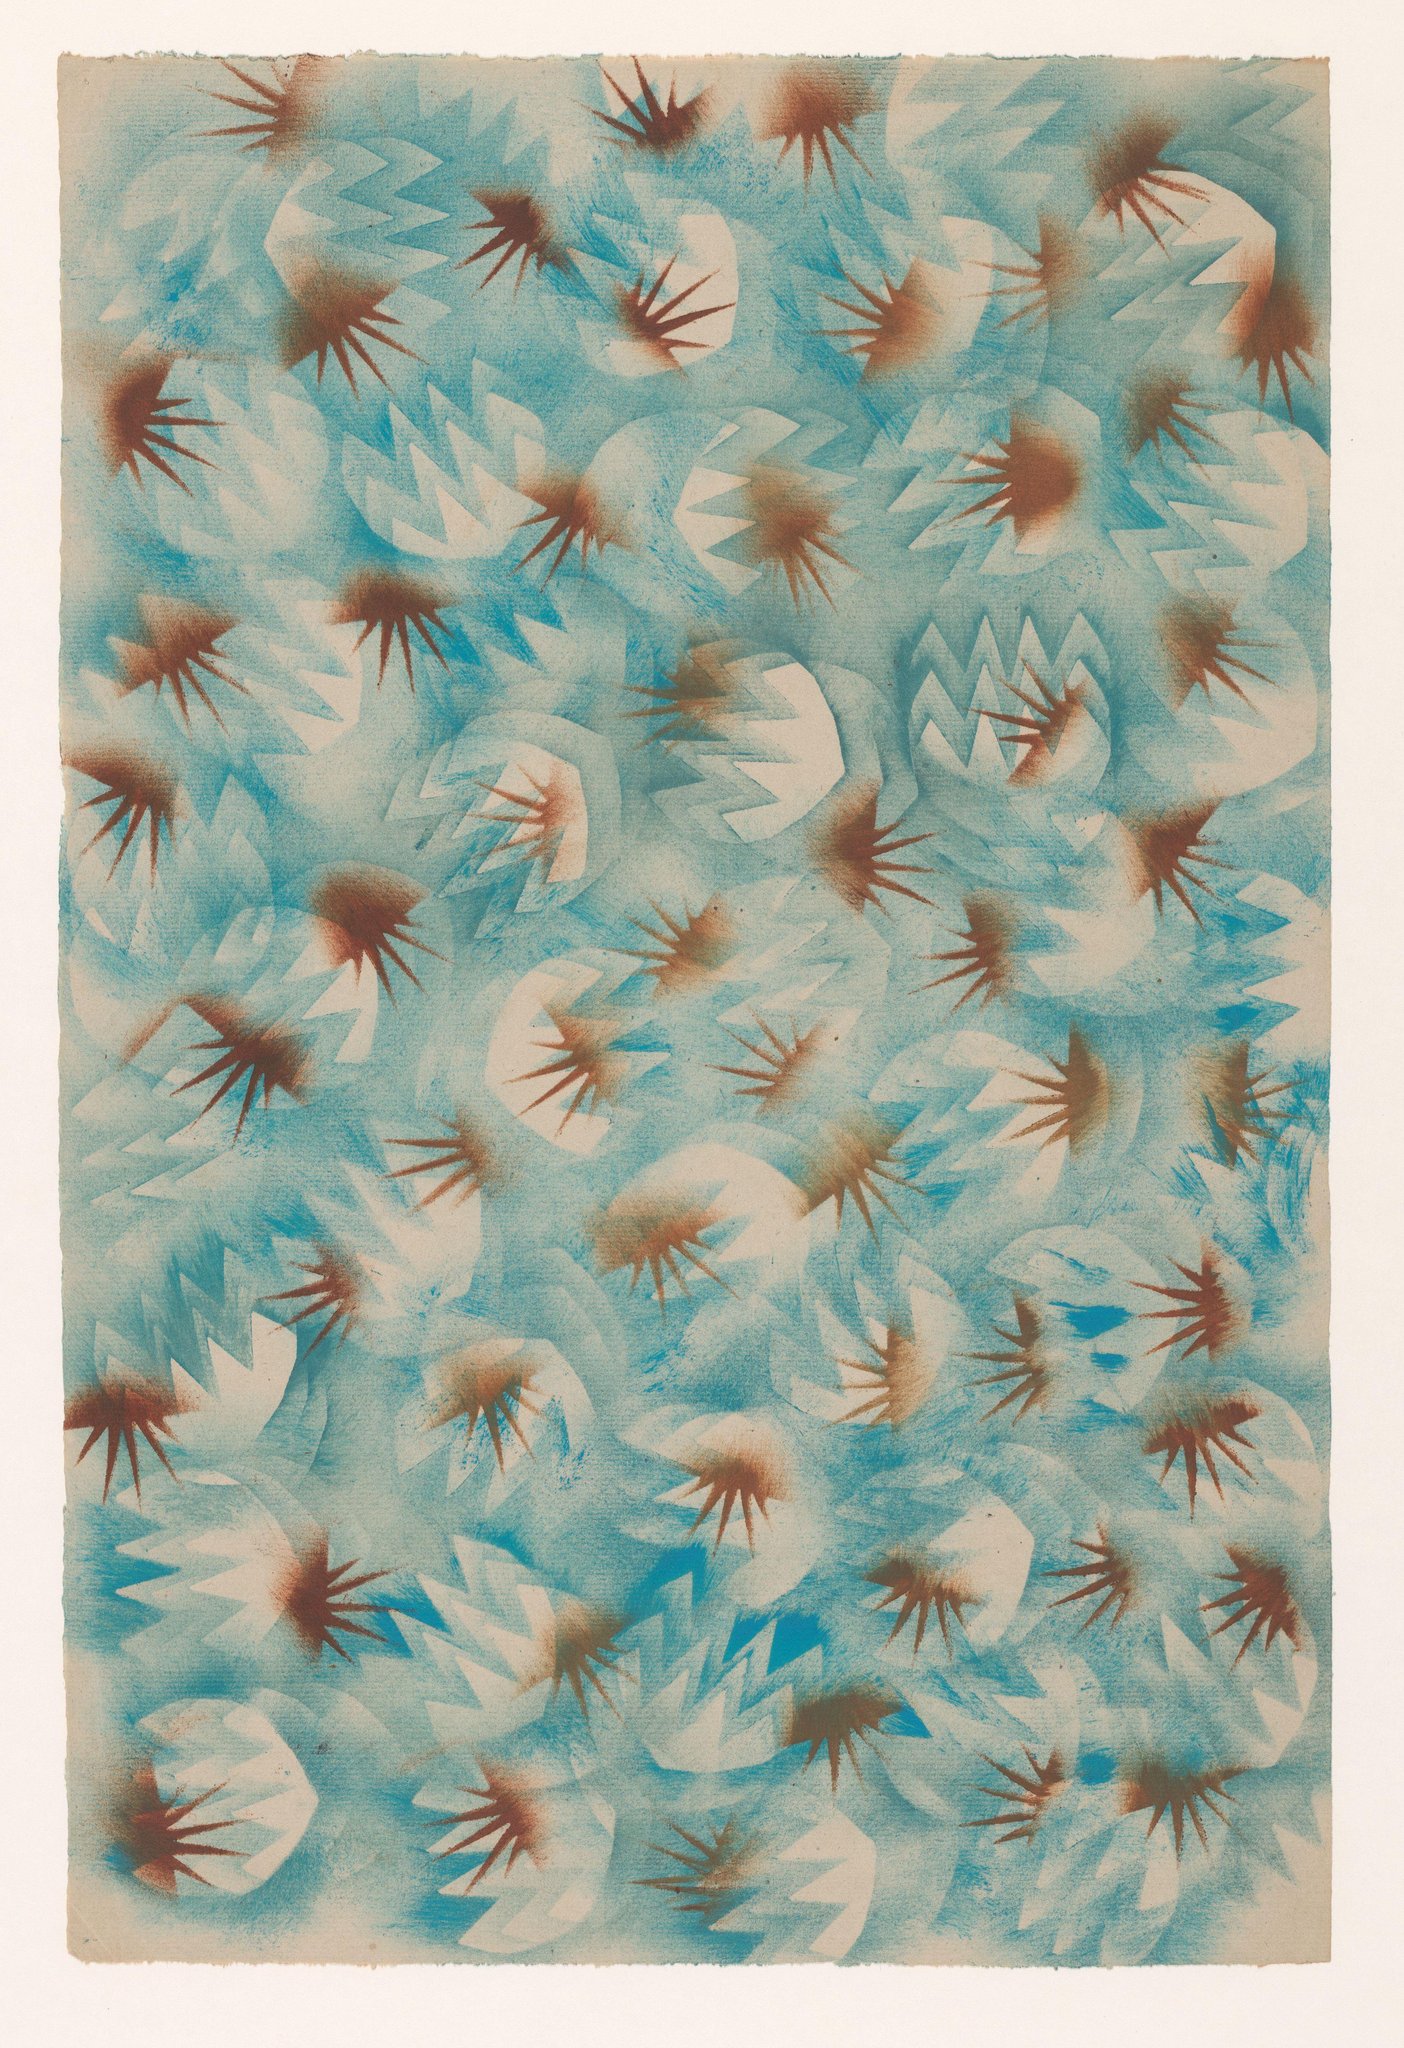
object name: decorated paper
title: Gesjabloneerd papier met patroon van gekartelde motieven in blauw en bruin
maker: Anonymous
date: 1900-1969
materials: paint, paper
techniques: stenciling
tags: fantasy ornament